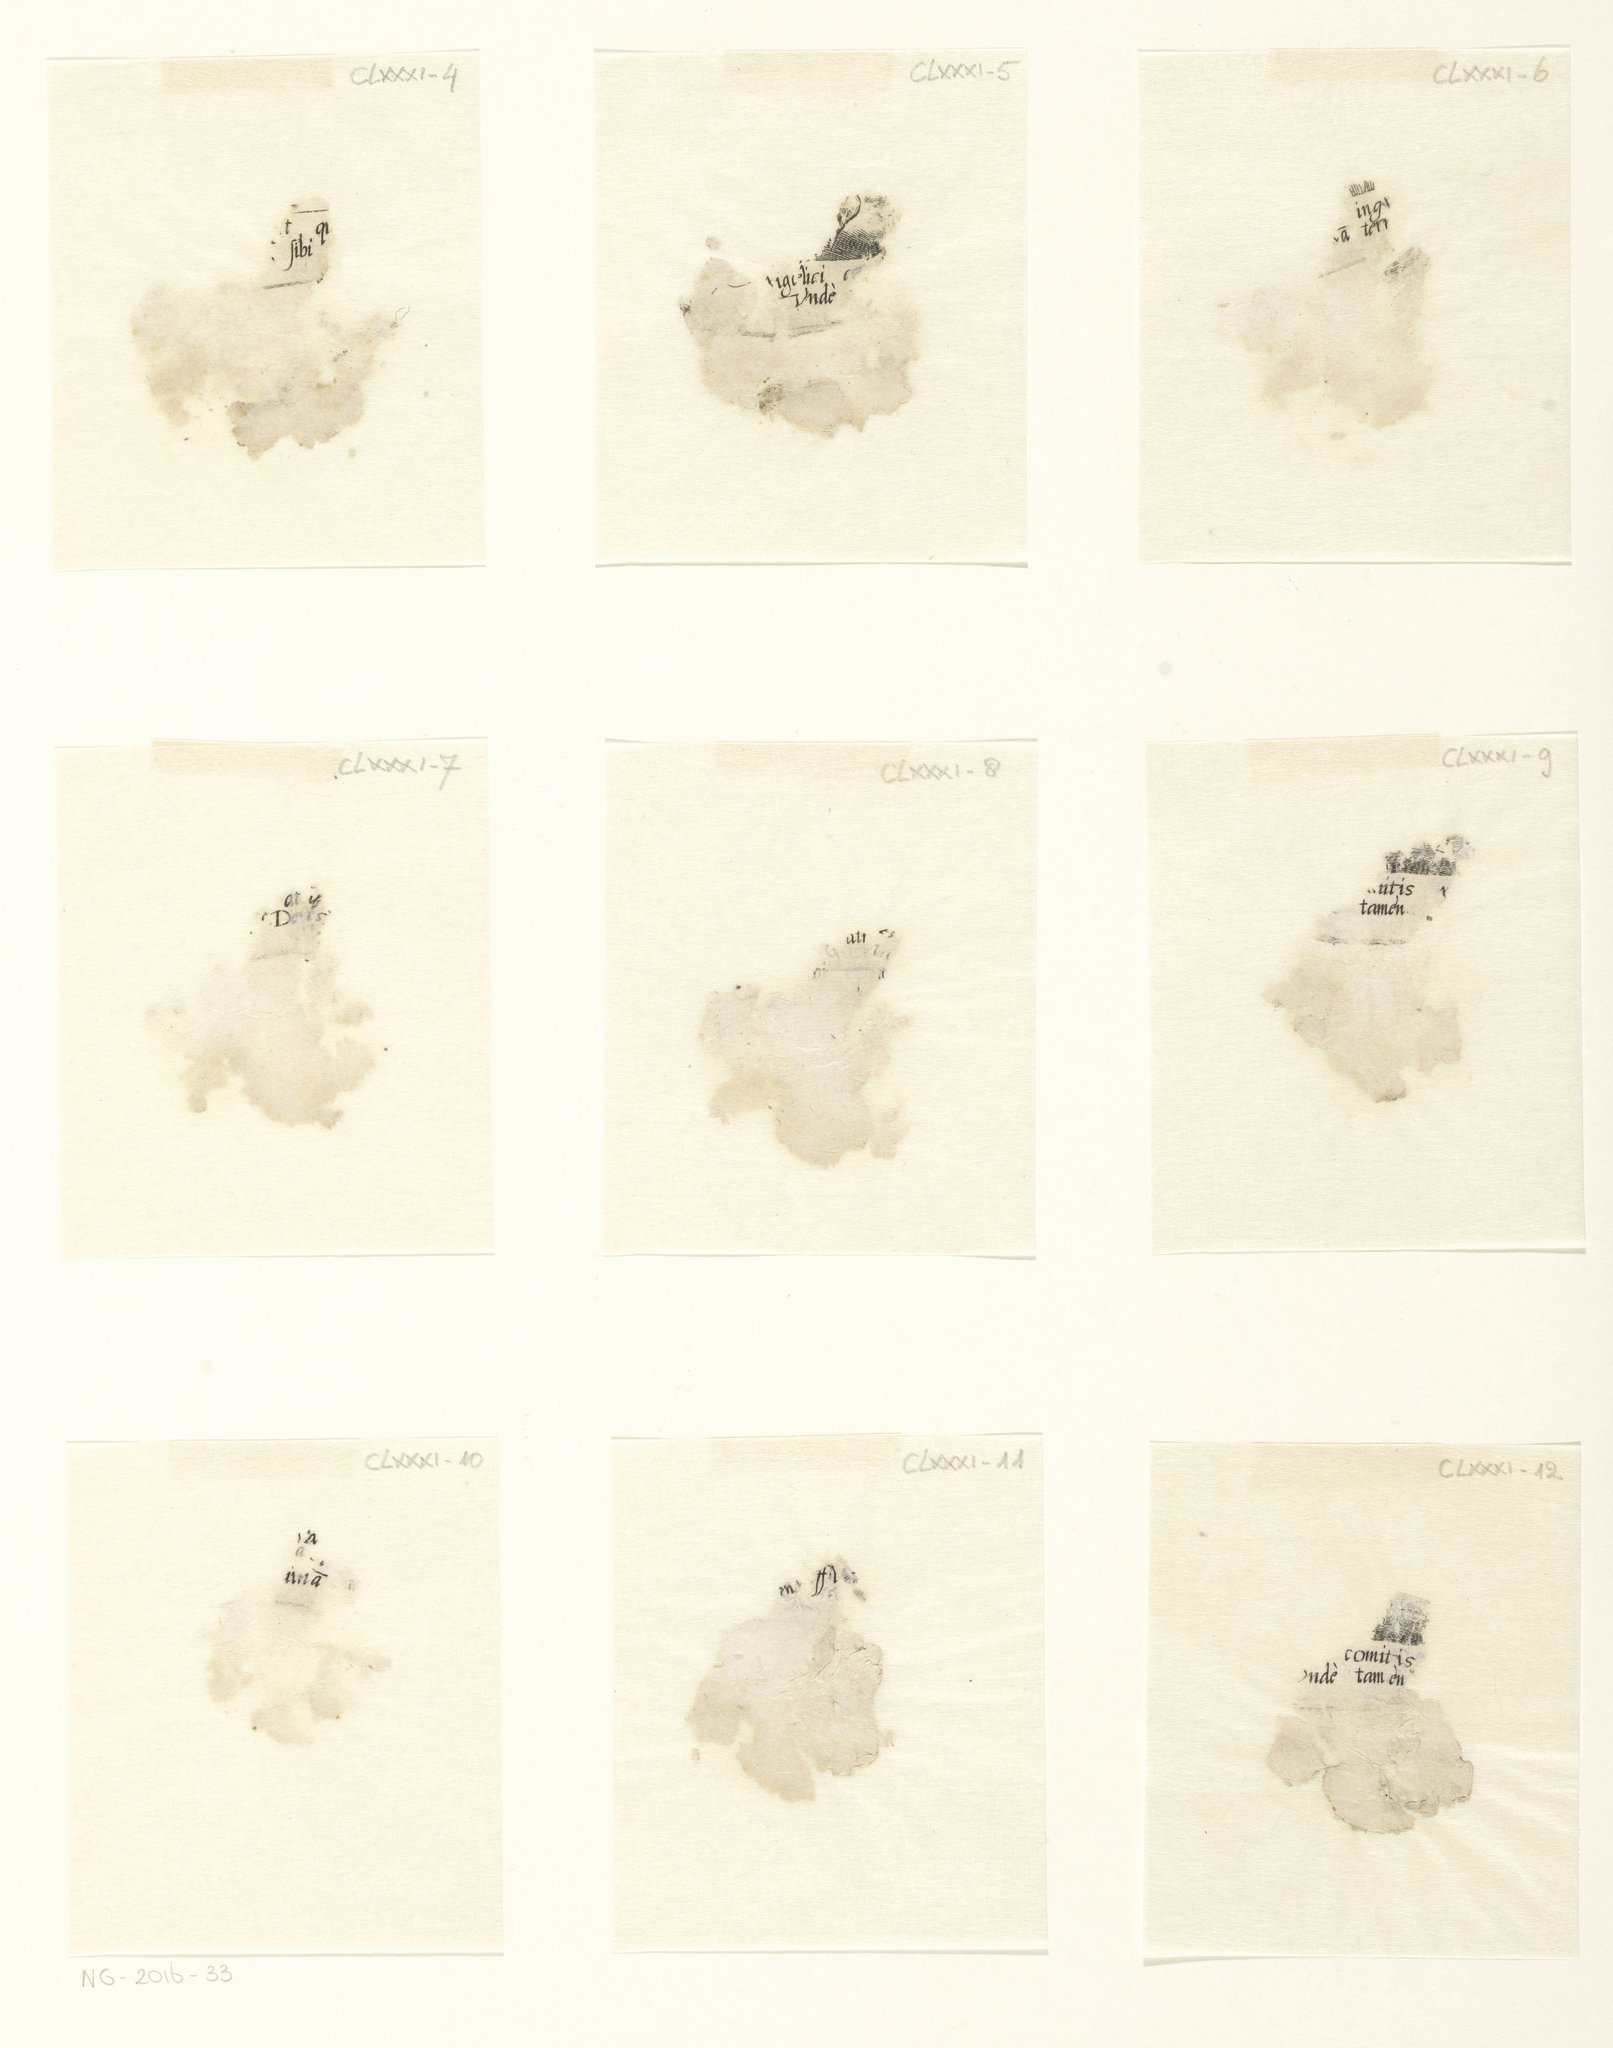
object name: print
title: Geschiedenis van Tobias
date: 1580-1596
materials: paper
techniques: engraving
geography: northern netherlands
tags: story of tobias: tobias' return (tobit 10-13), story of tobias: tobias and sarah (tobit 7-9), the journey to ecbatana (tobit 4-6)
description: De prenten in de Nova Zembla collectie zijn tijdens een expeditie van Willem Barendsz en Jacob van Heemskerk in 1596-1597 noodgedwongen in het winterkamp, het ‘Behouden Huis’, op het eiland achtergelaten. De prenten waren in één of meerdere stapels als handelswaar meegenomen vanuit Amsterdam. Bijna drie eeuwen later, in 1871, keerde de Noor Elling Carlsen terug naar Nova Zembla en vond daar de restanten van het ‘Behouden Huis, inclusief een groot deel van de inventaris. Een deel van de prenten, in de vorm van aaneengekoekte kluiten, werd toen ook teruggevonden. De papierkluiten waren soms op meerdere plekken gebroken. Tussen 1975-1979 zijn de prenten van elkaar gescheiden. Dit leverde in totaal ca. 1000 fragmenten van ca. 400 afdrukken van ca. 150 verschillende prenten op. Voor zover mogelijk zijn de fragmenten samengevoegd en zijn de prenten gereconstrueerd.